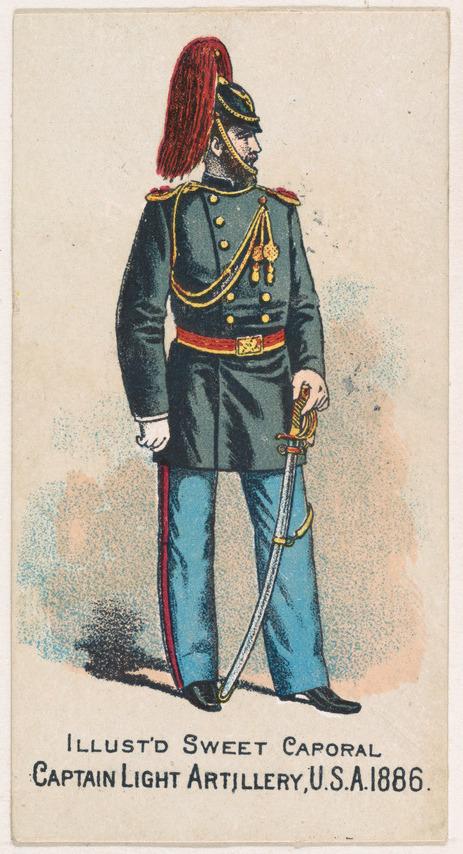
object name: print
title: Captain, Light Artillery, United States Army, 1886, from the Military Series (N224) issued by Kinney Tobacco Company to promote Sweet Caporal Cigarettes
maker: kinney brothers tobacco company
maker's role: publisher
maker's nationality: american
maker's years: 1869-2011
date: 1888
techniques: color lithograph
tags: soldiers,swords,men,profiles